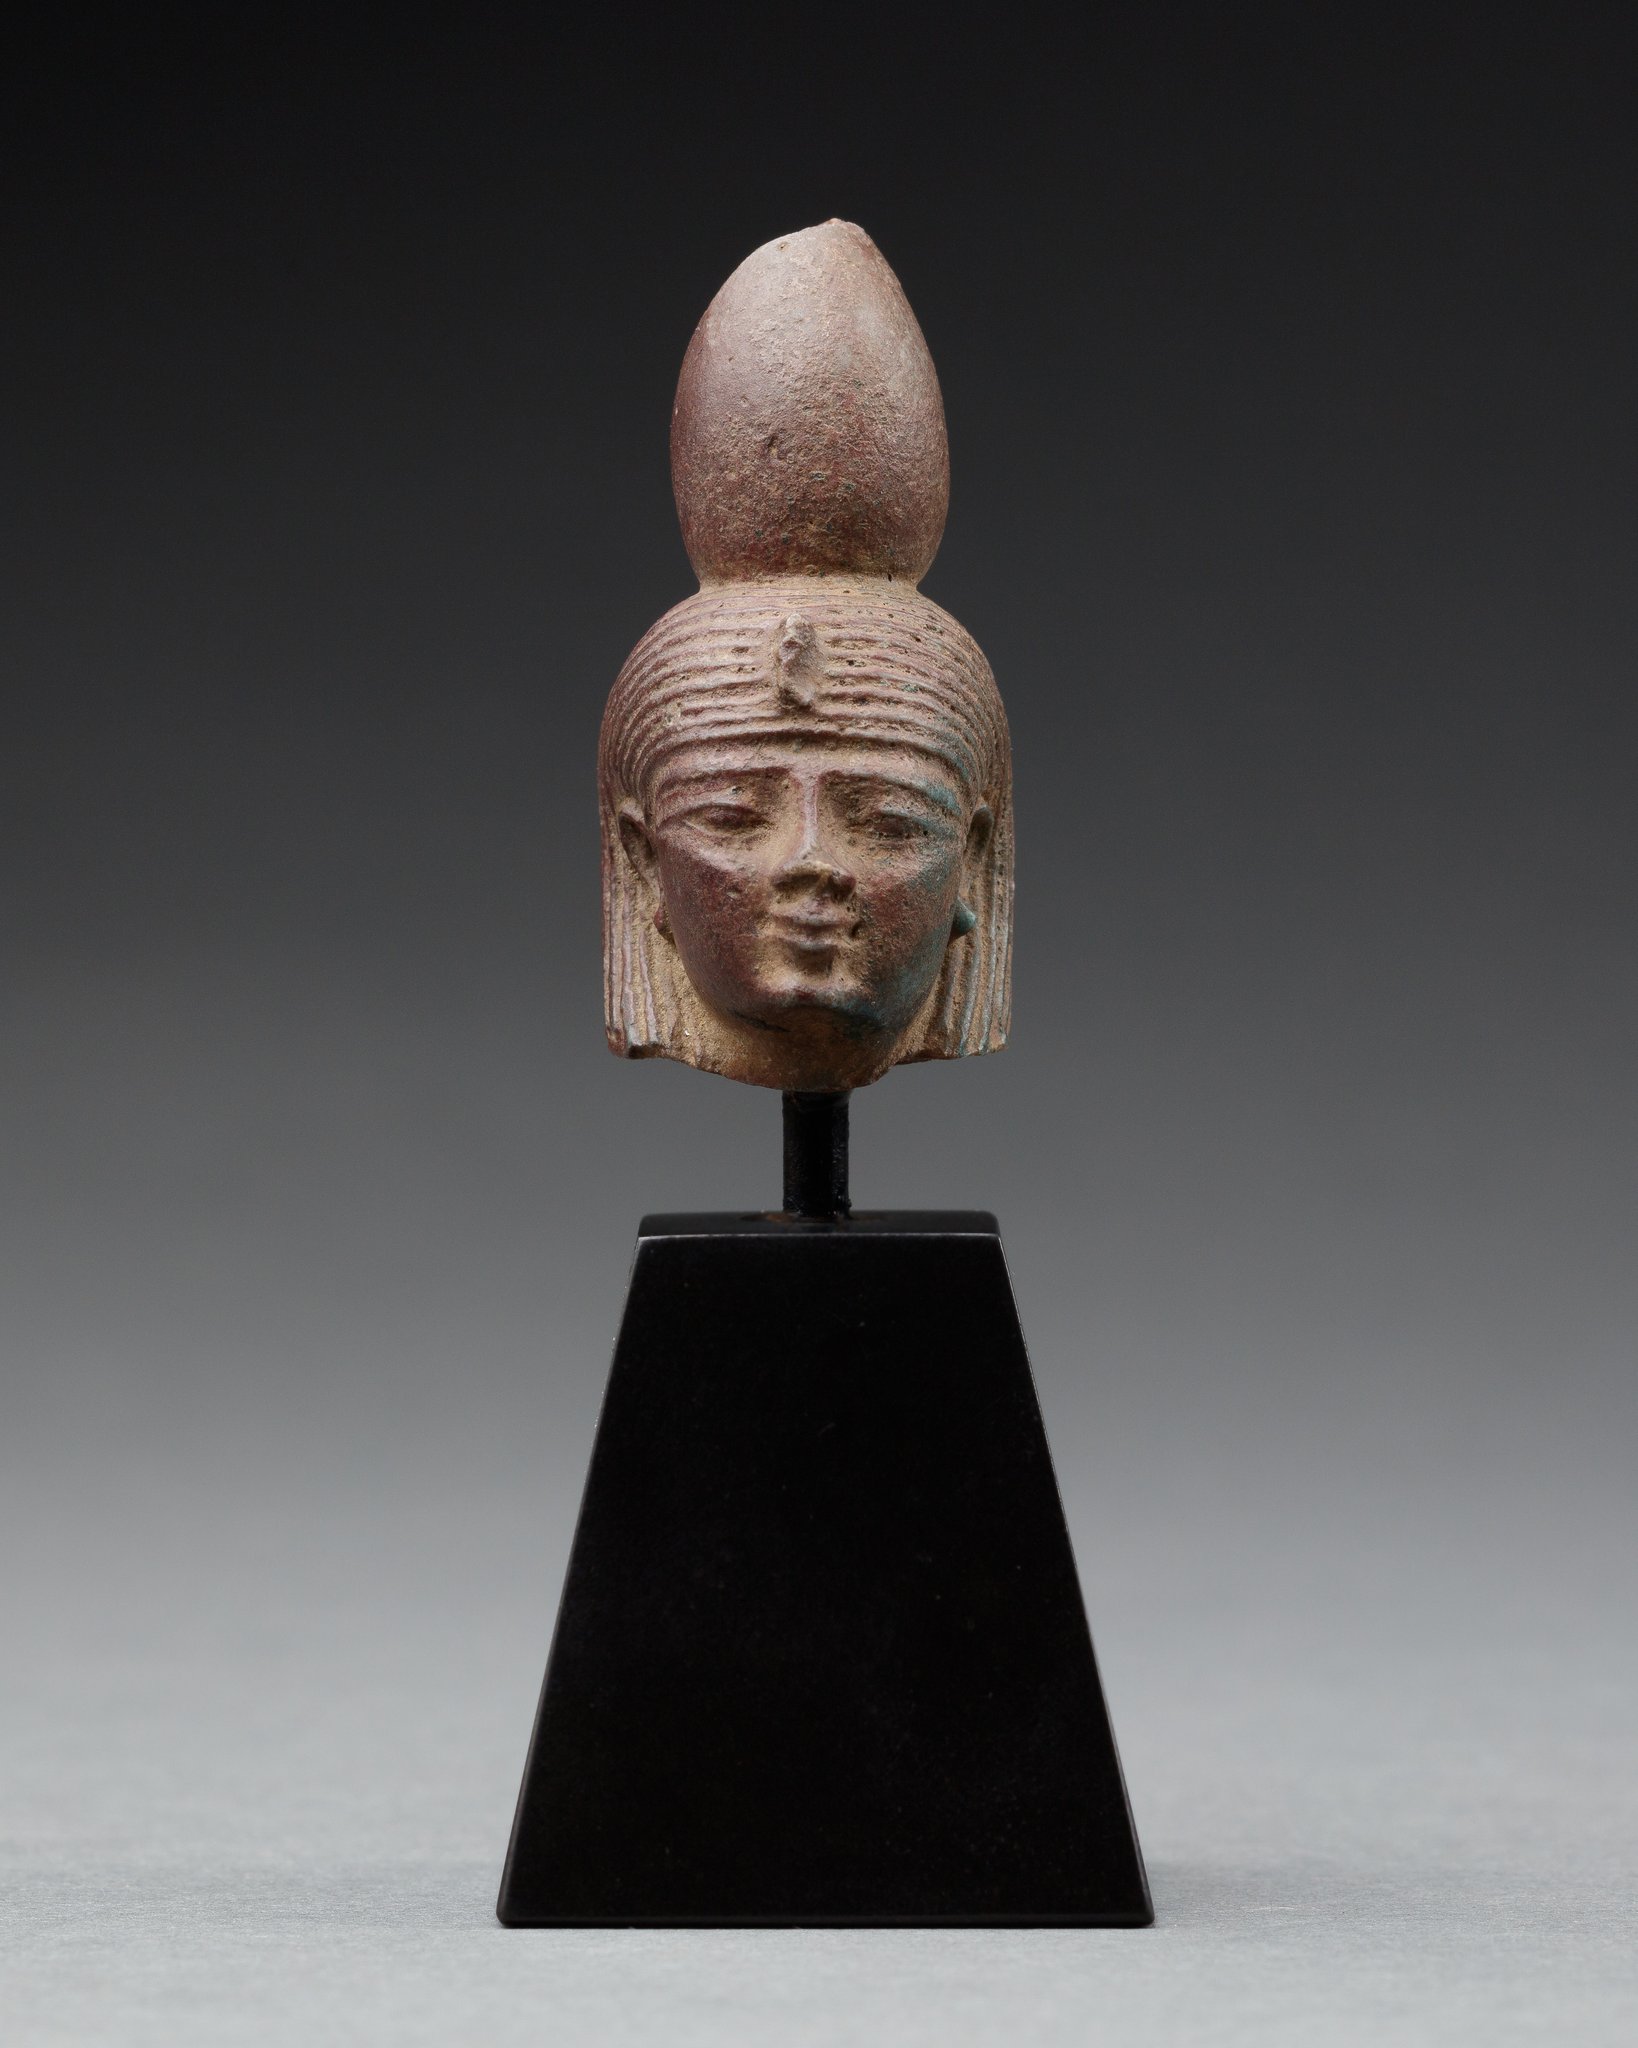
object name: head of a goddess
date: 550-530 BCE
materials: stone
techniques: glazing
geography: egypt